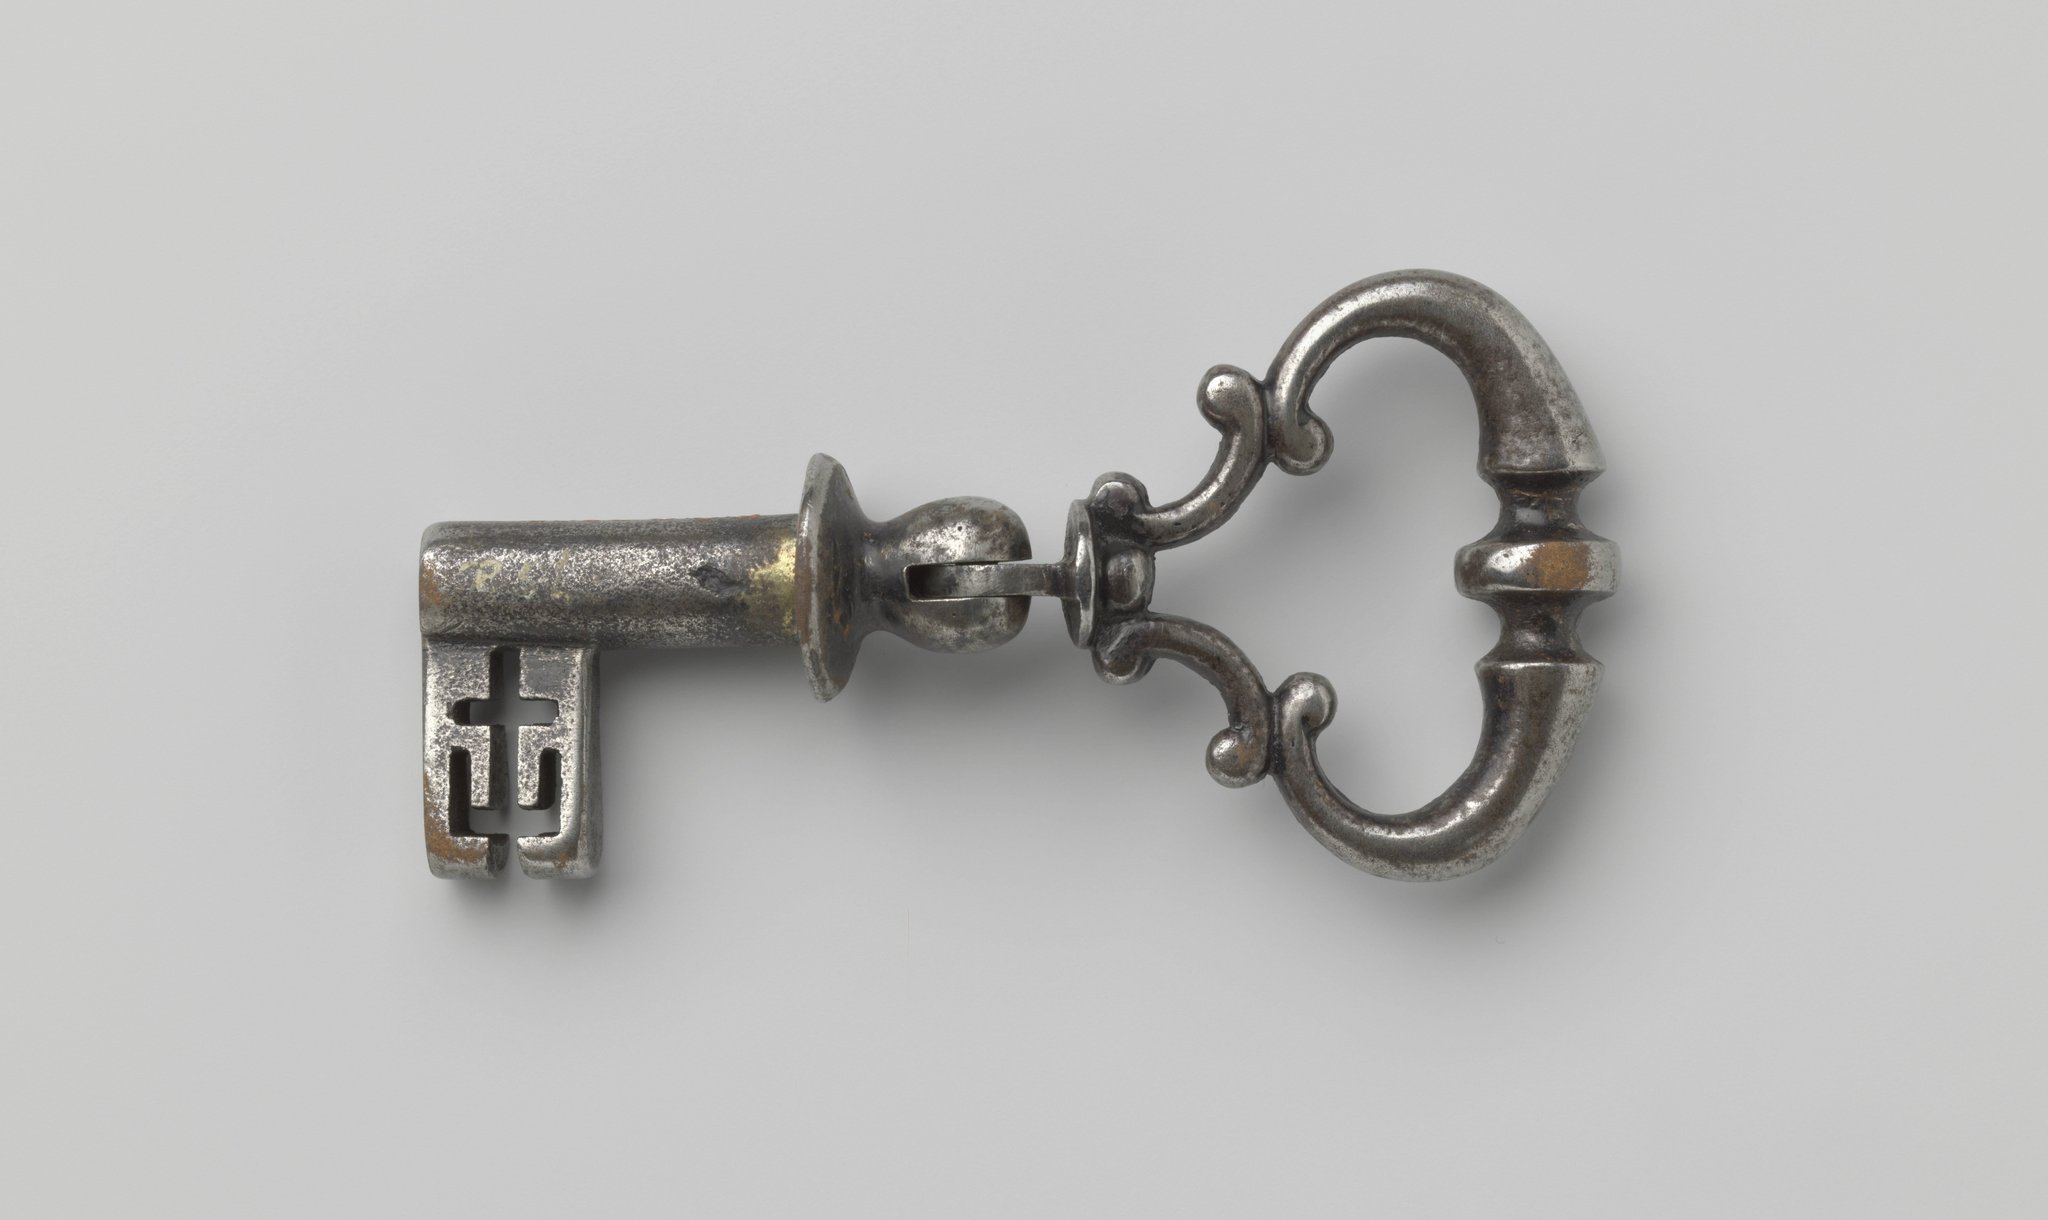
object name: pipe key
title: Pijpsleutel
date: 1700-1800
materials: iron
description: Pijpsleutel waarvan de schacht en greep door een scharnier verbonden zijn. De greep bestaat uit een schijf van waar twee kleine naar buiten gewende C-voluten oprijzen. Deze dragen een naar beneden gewende en in het midden ingesneden, geprofileerde grote C-voluut. De sleutelborst is schijfvormig.